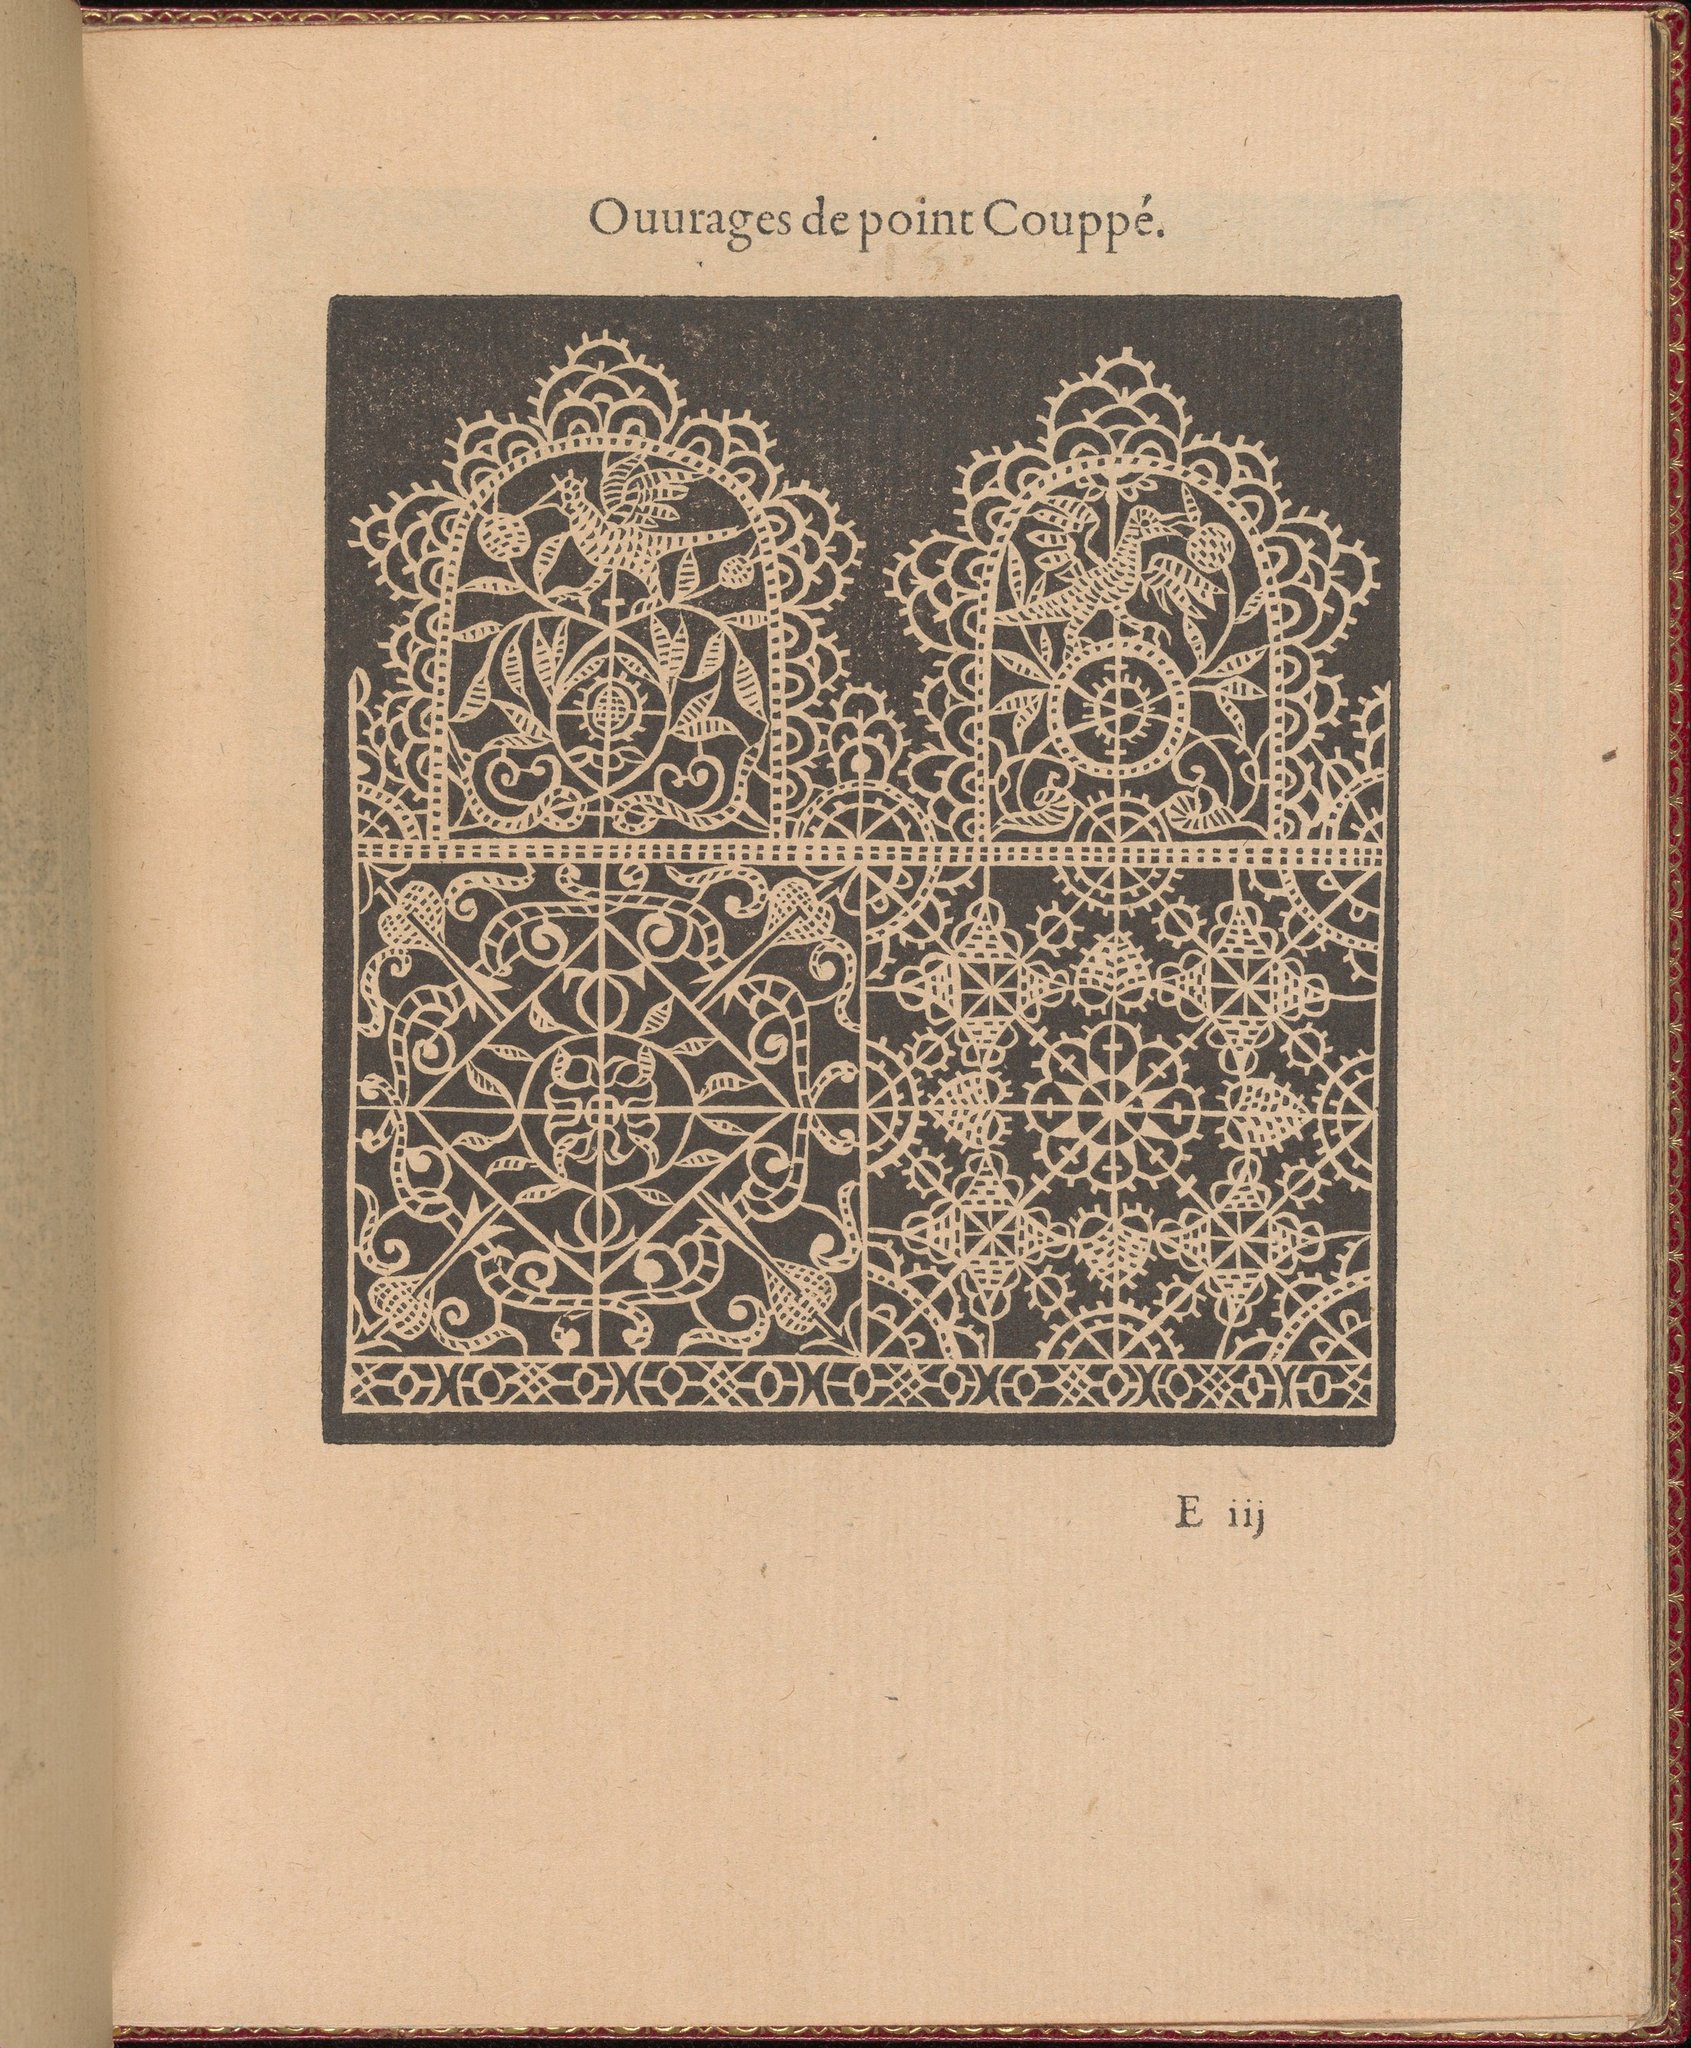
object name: book print ornament architecture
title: Les Singuliers et Nouveaux Portraicts... page 19 (recto)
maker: federico de vinciolo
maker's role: designer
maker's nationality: italian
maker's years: 1582-1599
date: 1588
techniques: woodcut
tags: birds,ornament